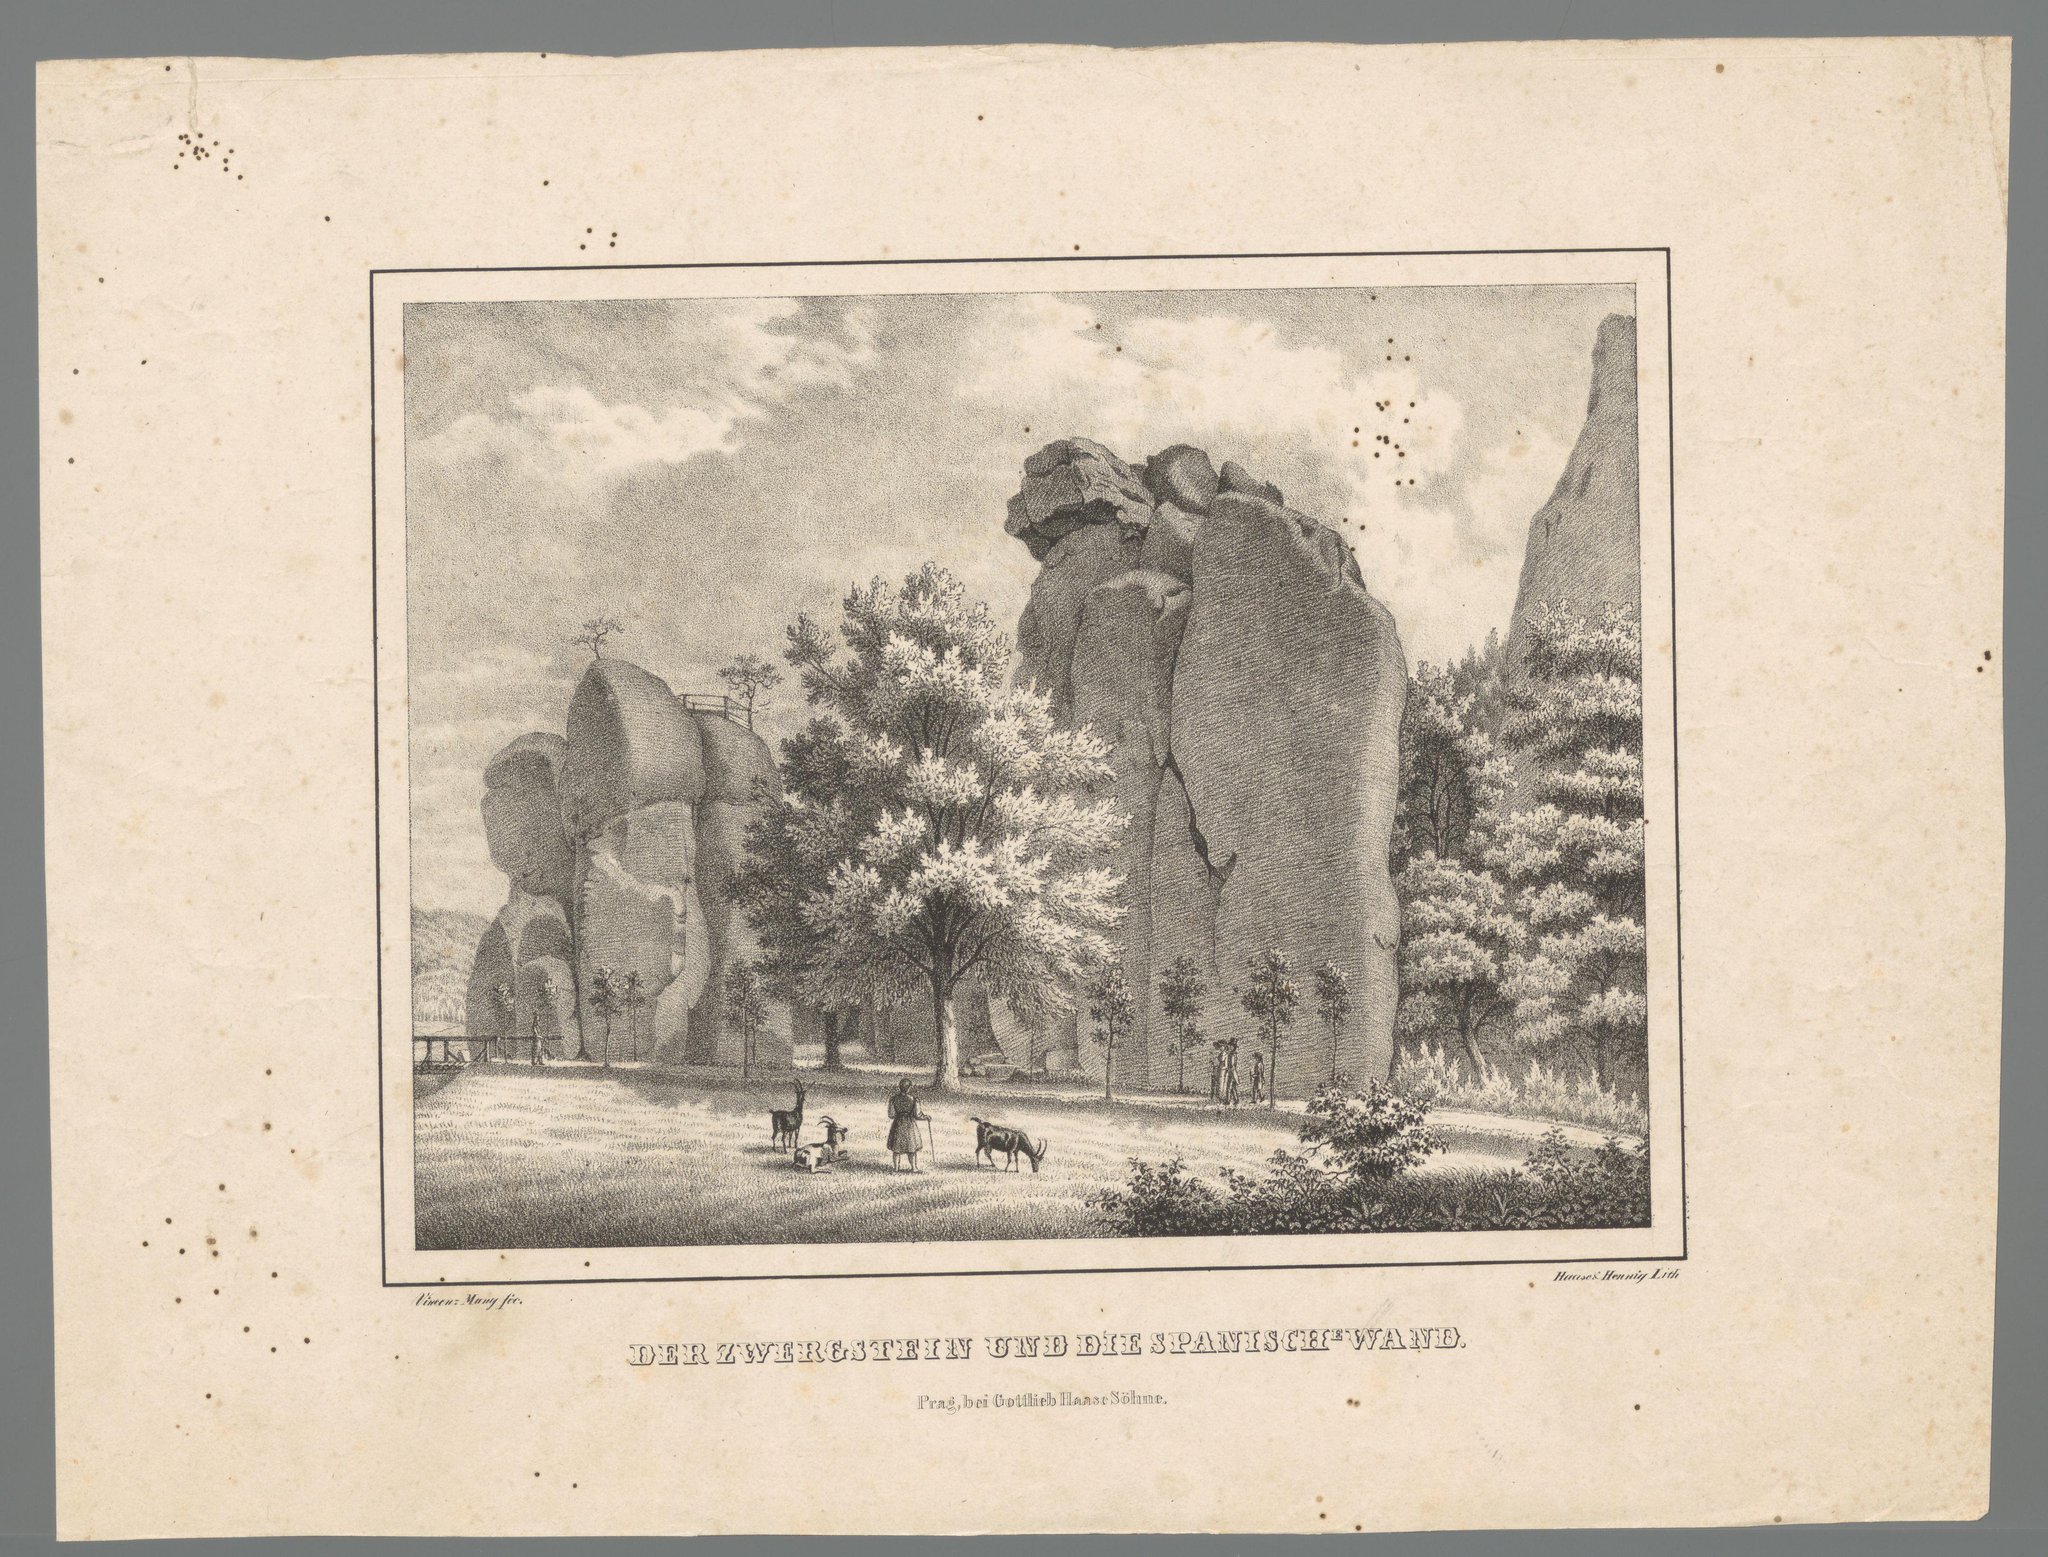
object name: print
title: Der Zwergstein und die Spanische Wand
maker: vincenz mung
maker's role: print maker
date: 1820-1850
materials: paper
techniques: lithograph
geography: prague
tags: rock-formations, landscapes in the temperate zone (+ landscape with figures, staffage)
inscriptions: collector's mark: Lugt 2228